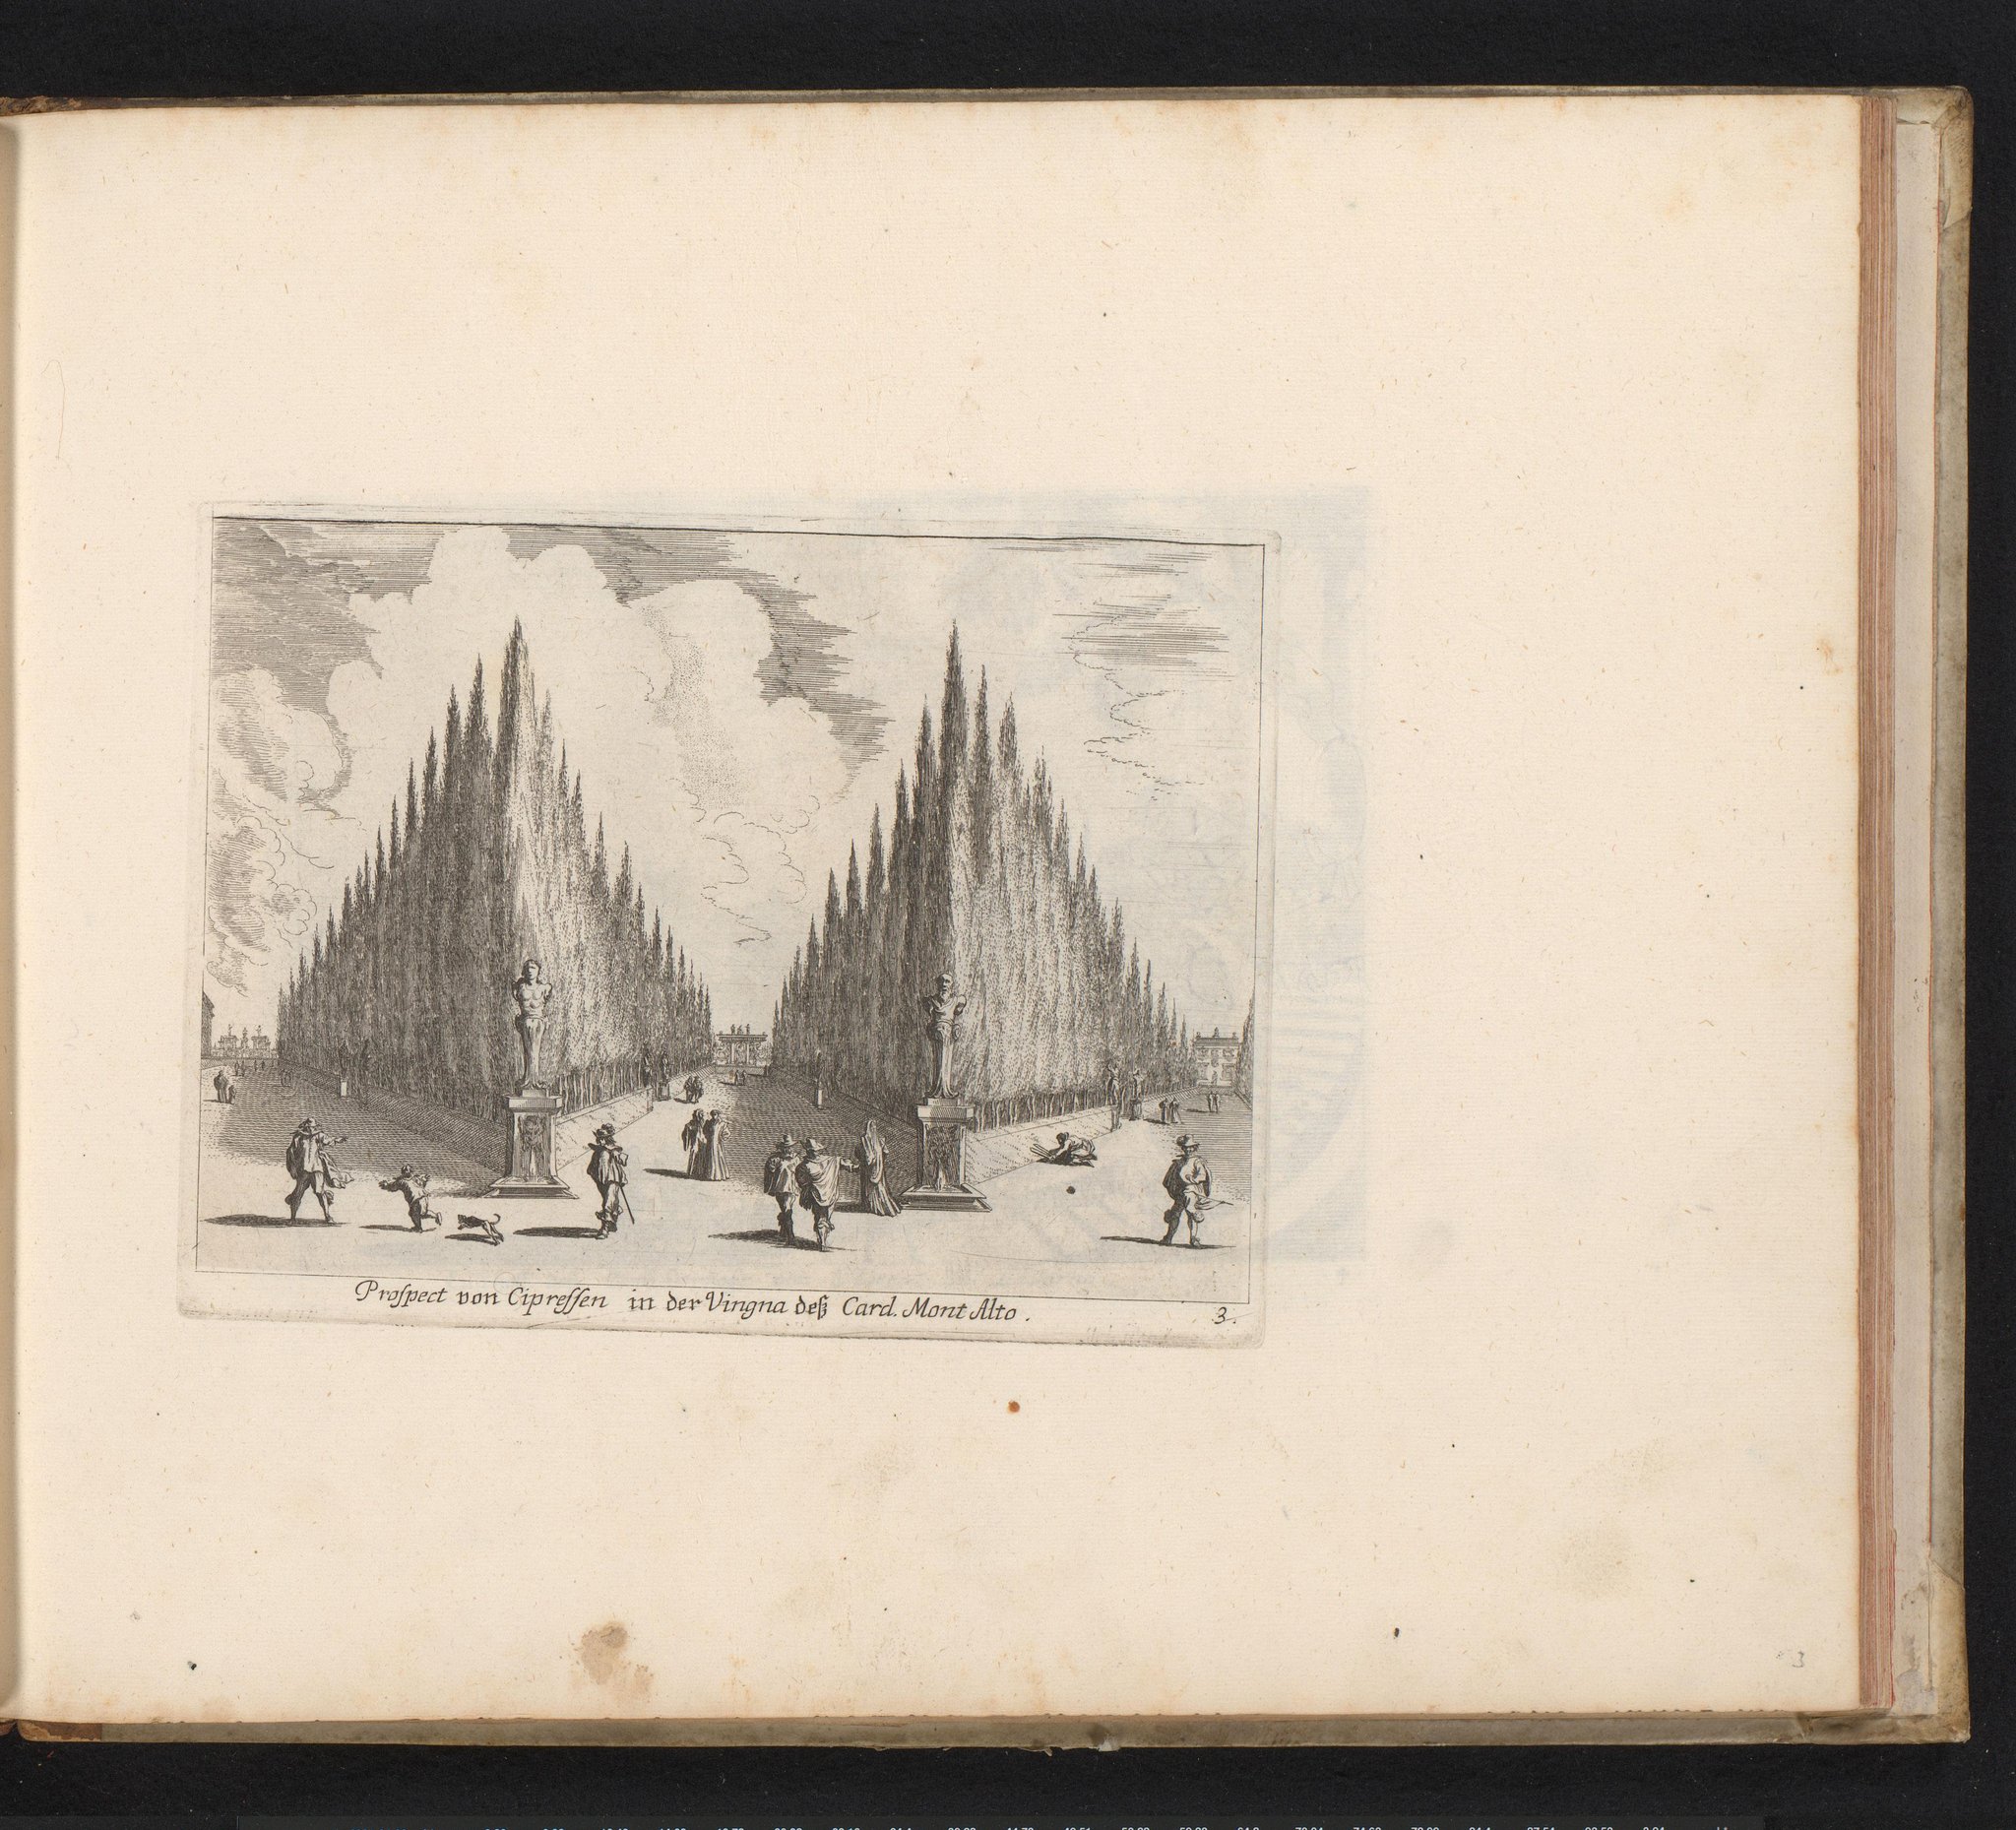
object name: album leaf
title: Tuin met cipressen bij de Villa Montalto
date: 1670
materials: paper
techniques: etching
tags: trees: cypress, rome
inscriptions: collector's mark: Lugt 2228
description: Tekst in het Duits in de ondermarge. Rechtsonder genummerd: 3. Prent maakt deel uit van een album.